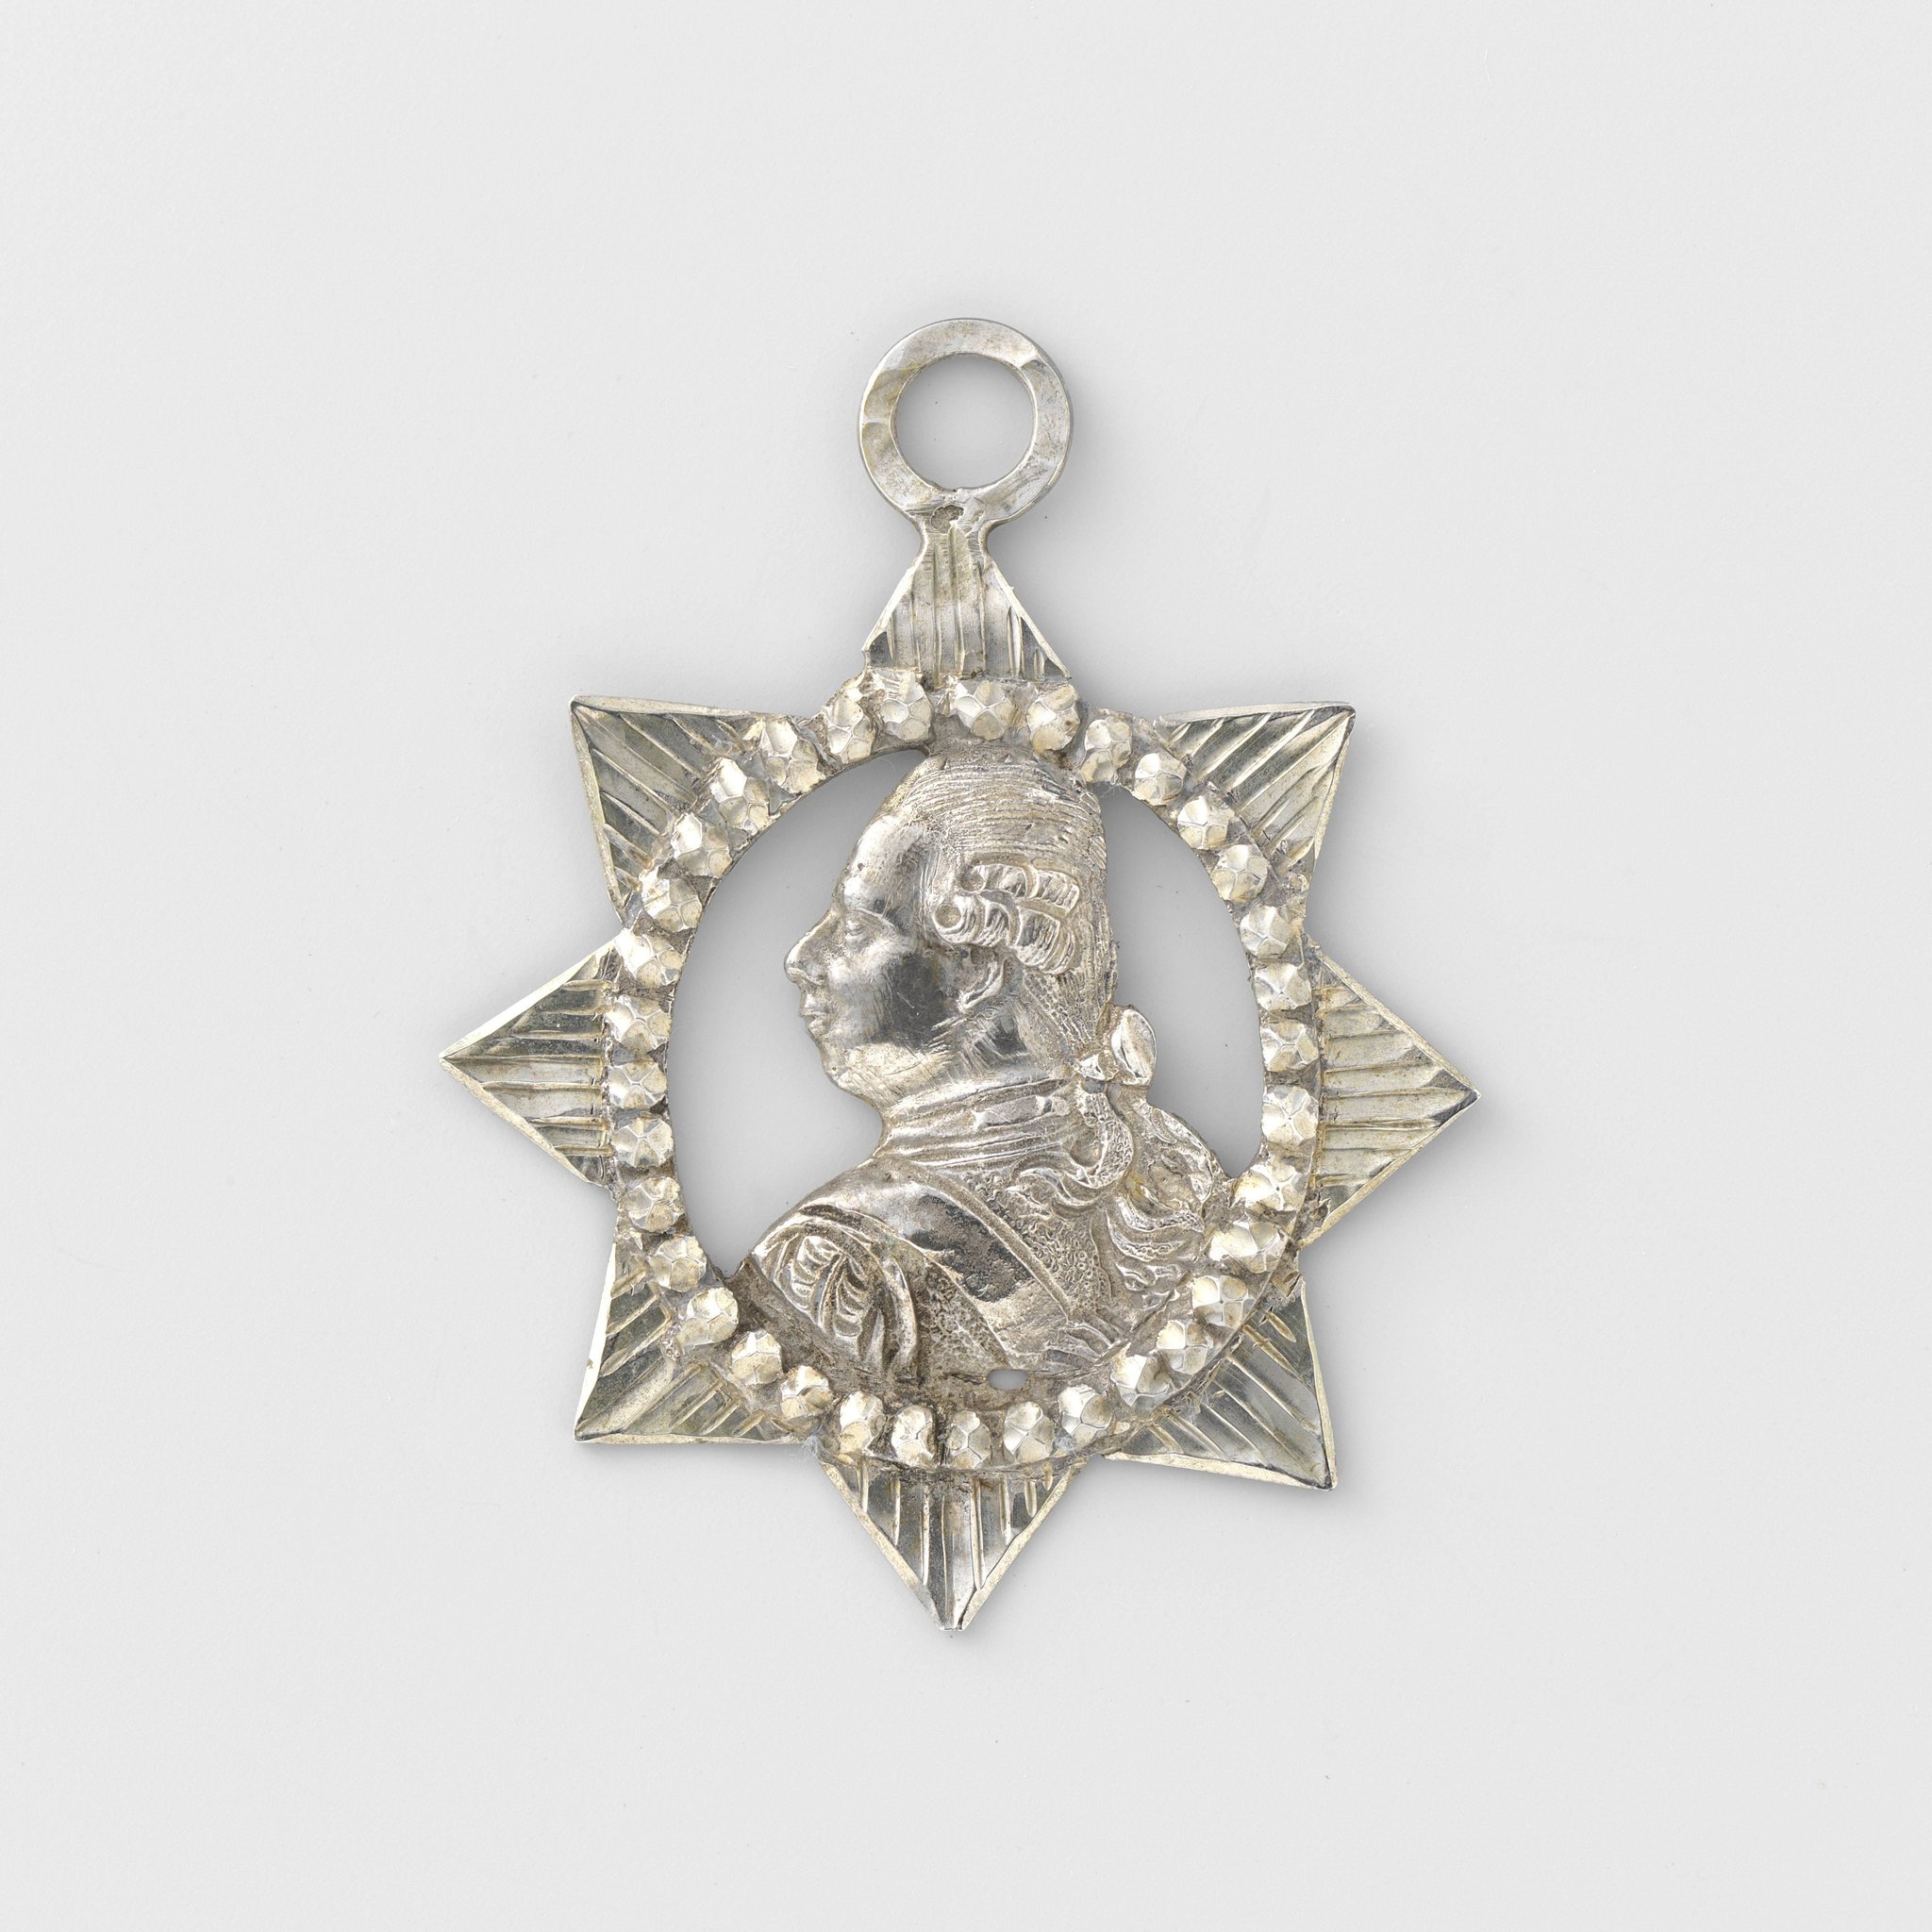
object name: insignia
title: Willem V, prins van Oranje-Nassau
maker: Anonymous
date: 1787-1795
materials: silver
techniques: embroidery, soldering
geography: netherlands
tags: the hague, william v (prince of orange), historical persons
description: Badges with portraits of Stadholder William V and his wife Wilhelmina of Prussia, c. 1780-1795.